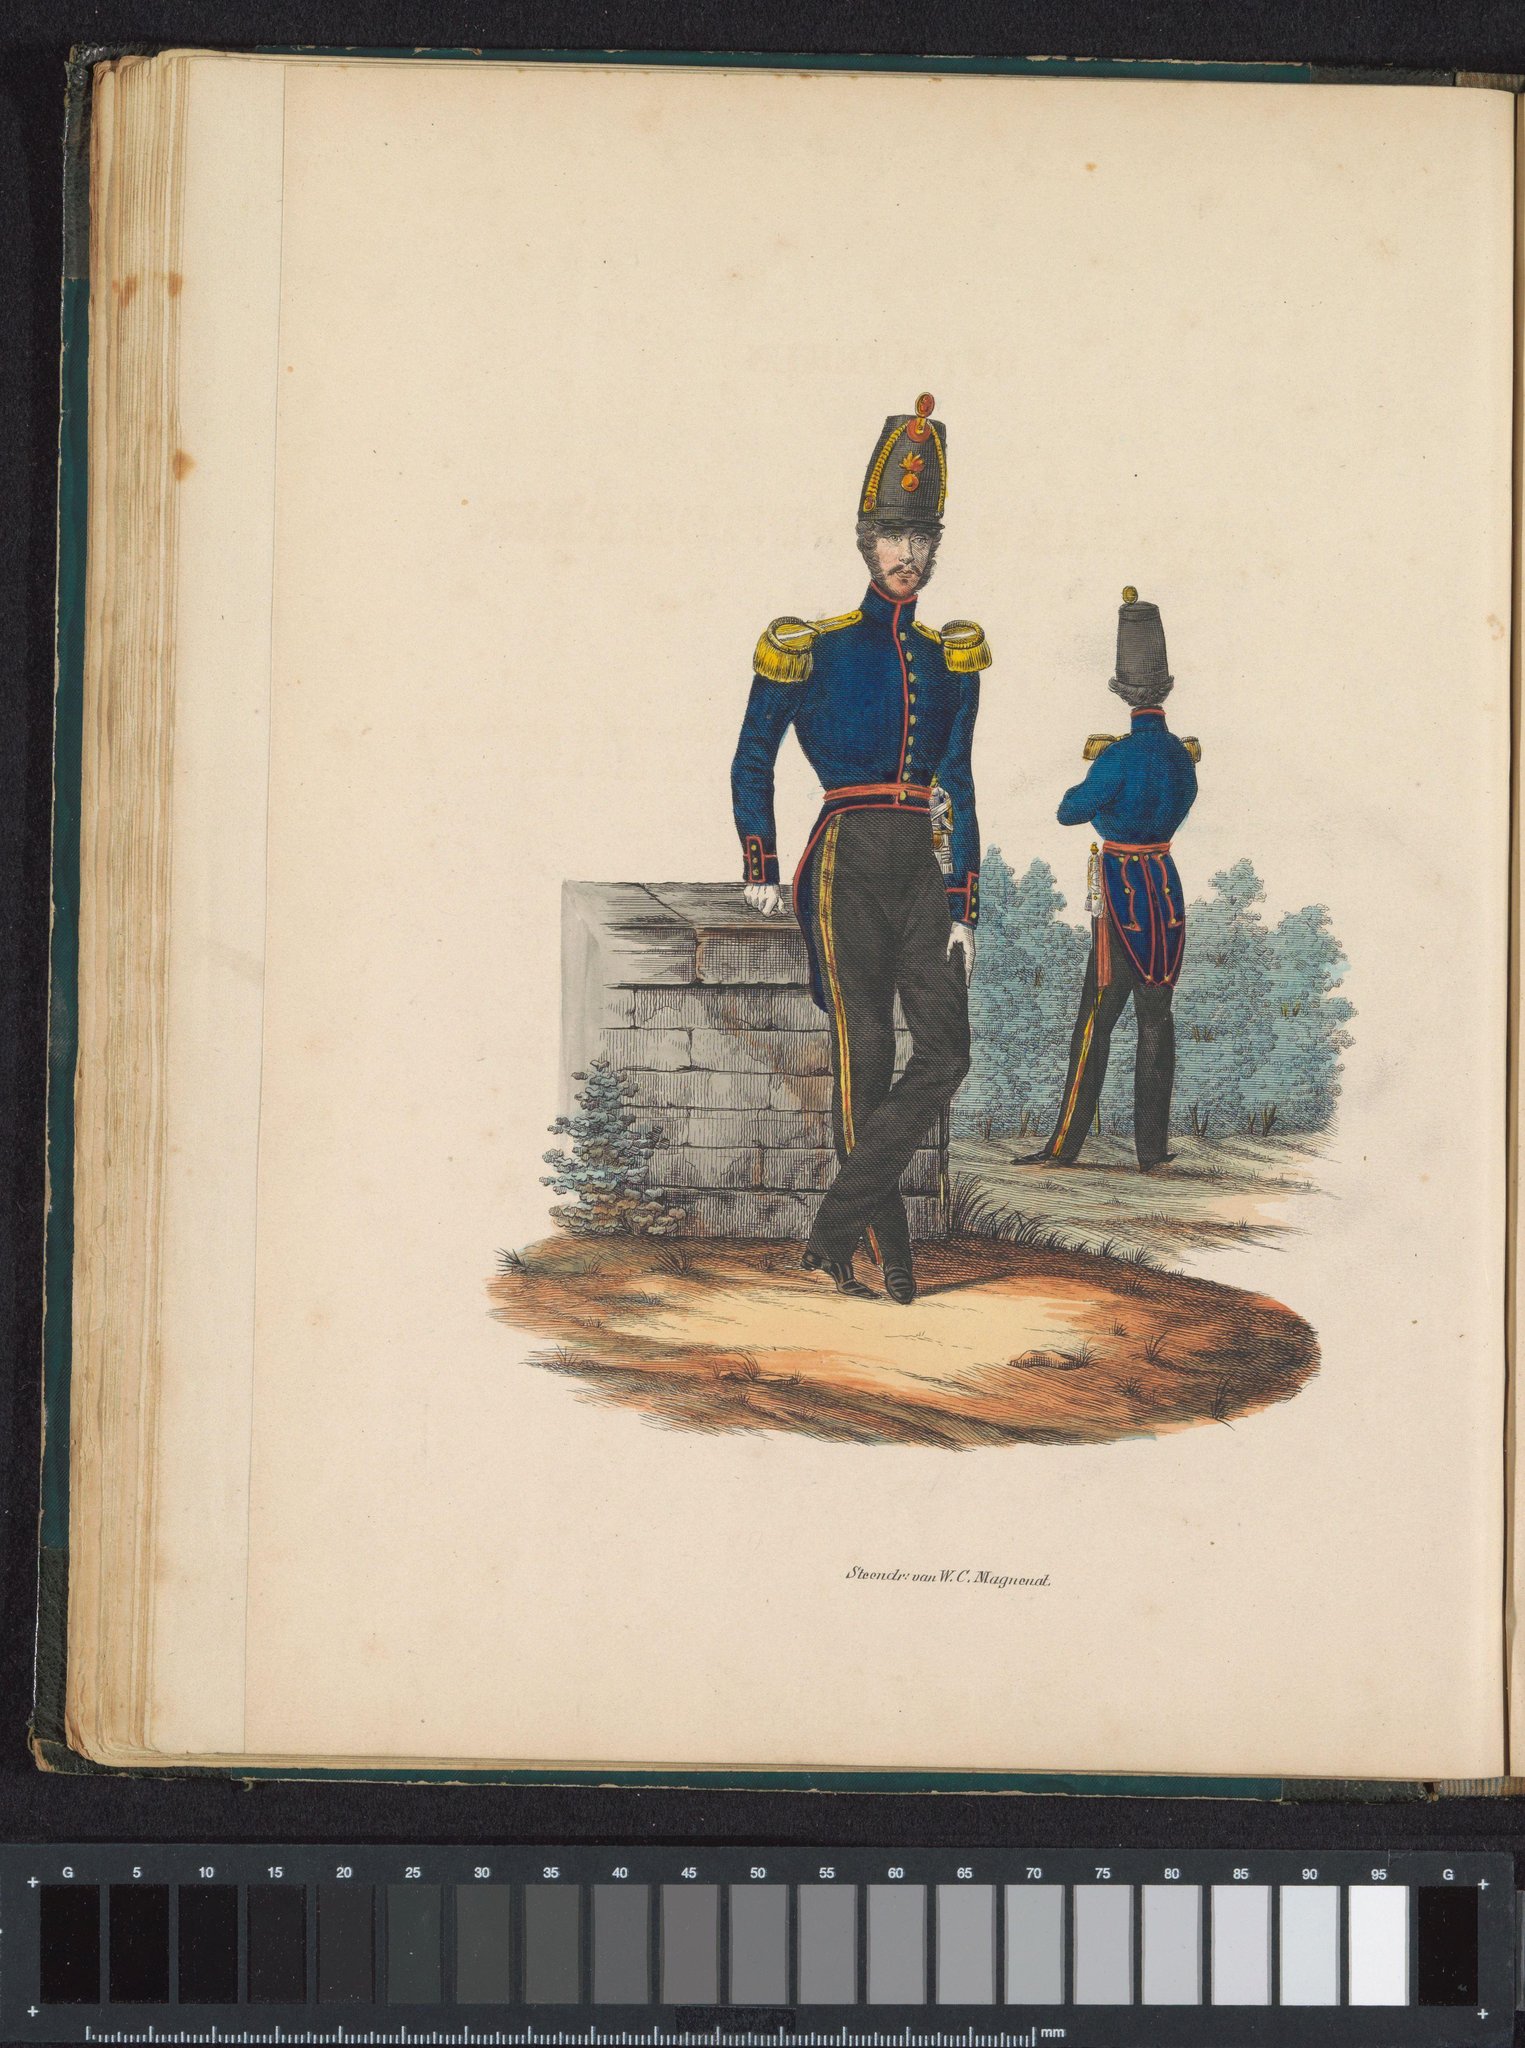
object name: print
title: Uniform van de officieren van de garnizoenstroepen, 1845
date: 1845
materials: paper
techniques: hand coloring, lithograph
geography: netherlands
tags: (military) uniforms, netherlands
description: Uniform van de officieren van de garnizoenstroepen. Illustratie in een boek uit 1845 over de uniformen en kledingstukken van de Nederlandse land-, zeemacht en schutterijen in Nederland en in de overzeese gebiedsdelen.